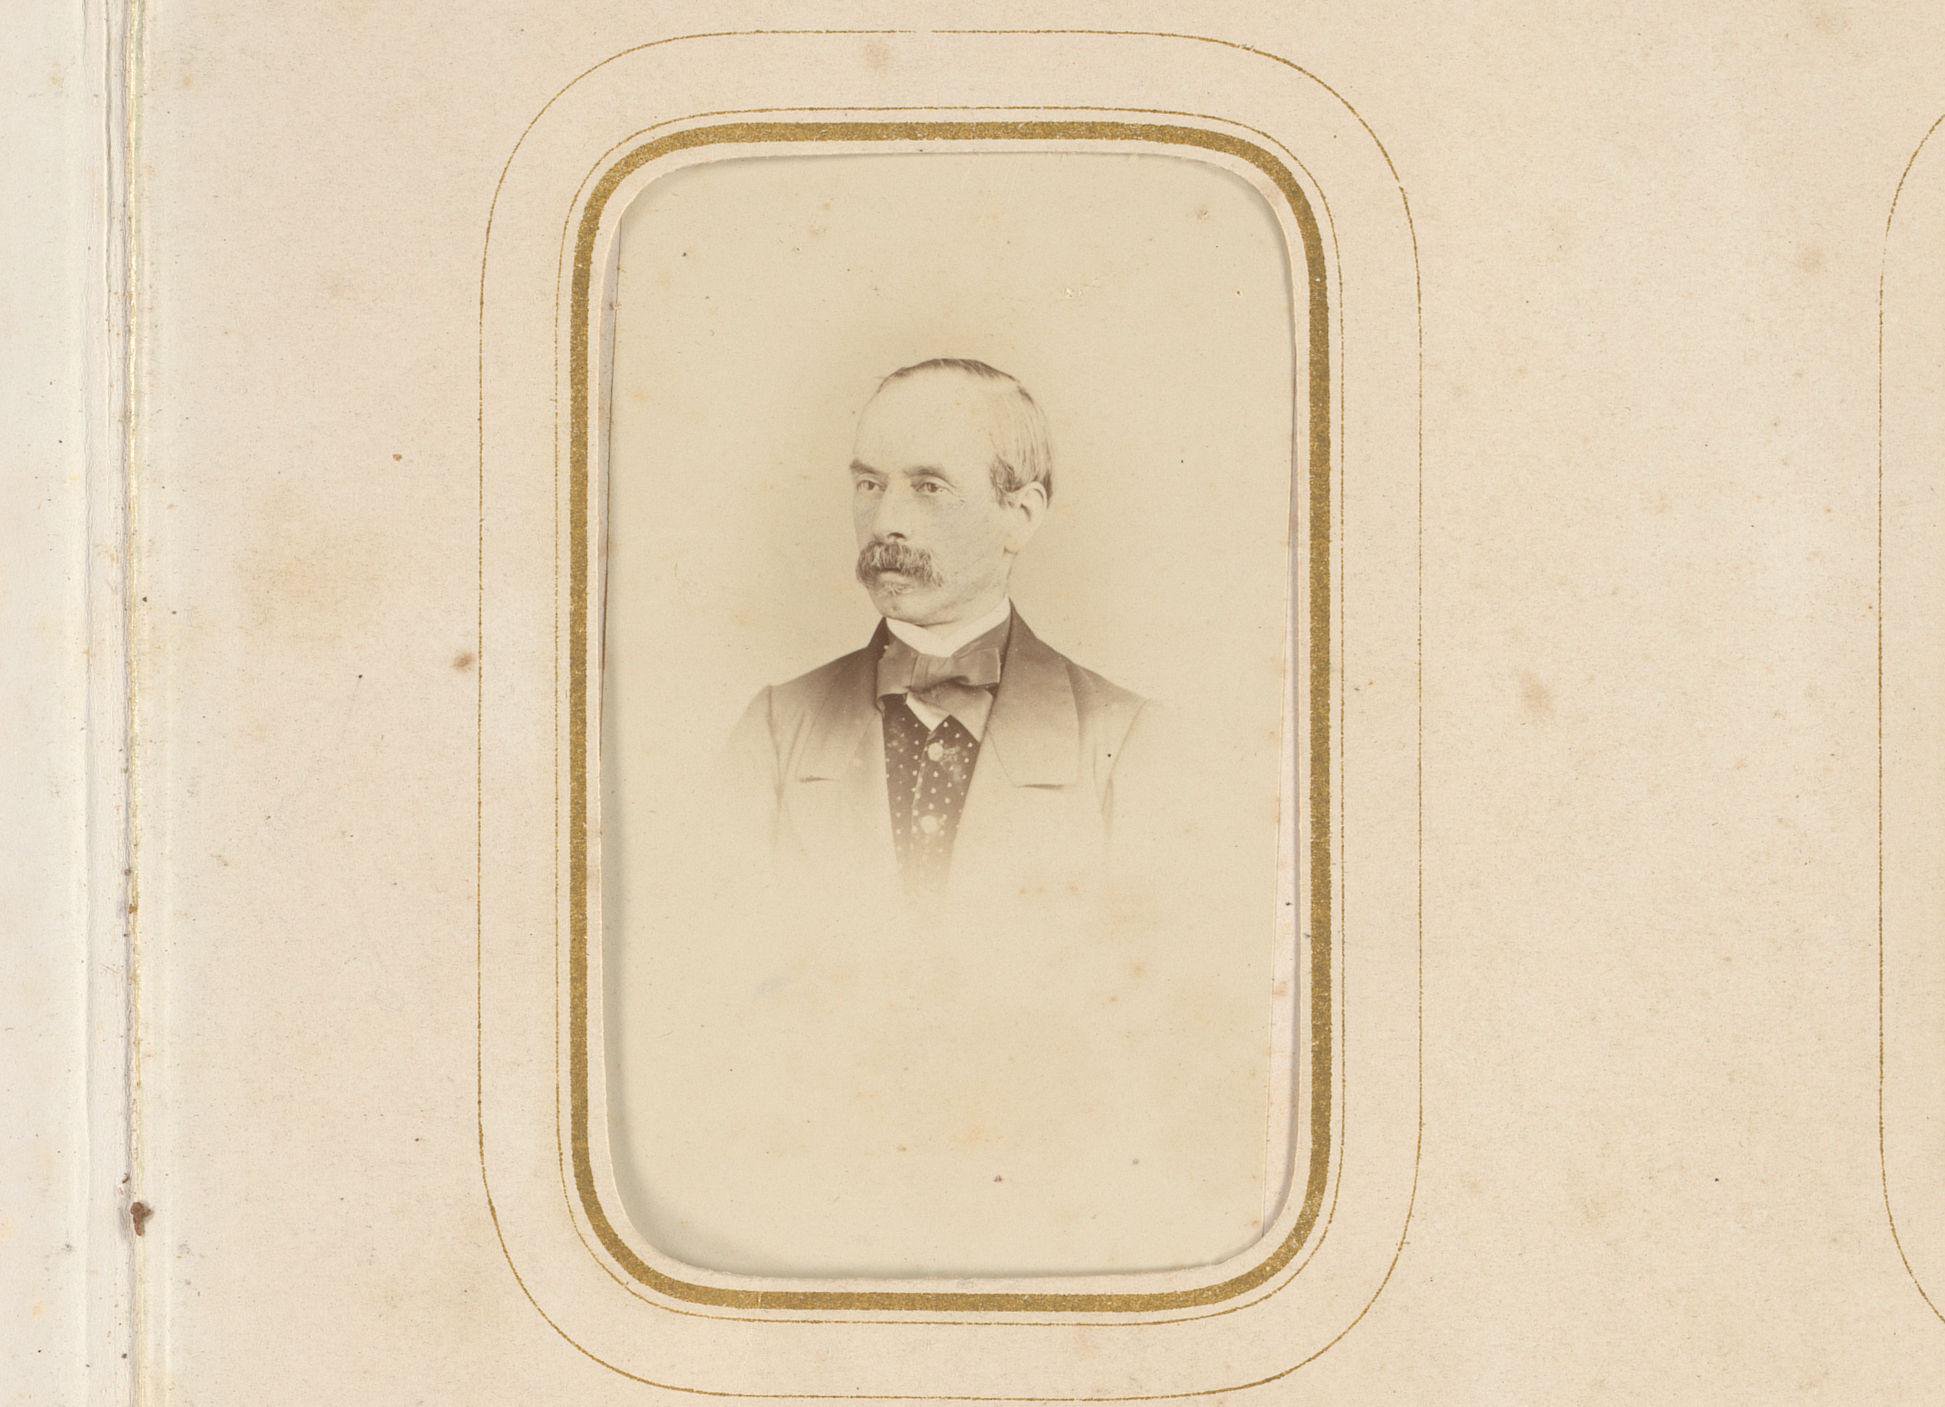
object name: carte de visite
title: Portret van een man met snor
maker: numa blanc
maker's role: publisher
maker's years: 1816-1897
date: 1867-1895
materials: cardboard, photographic support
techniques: albumen print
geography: paris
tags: moustache, historical persons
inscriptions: inscription: ‘Paris 1867/ Numa Blanc/ Langerock & Cie Succrs/ Peintres-Photographes/ de S.M. Le roi de Pruisse/ 29, Bould des Italiens, 29/ Paris’